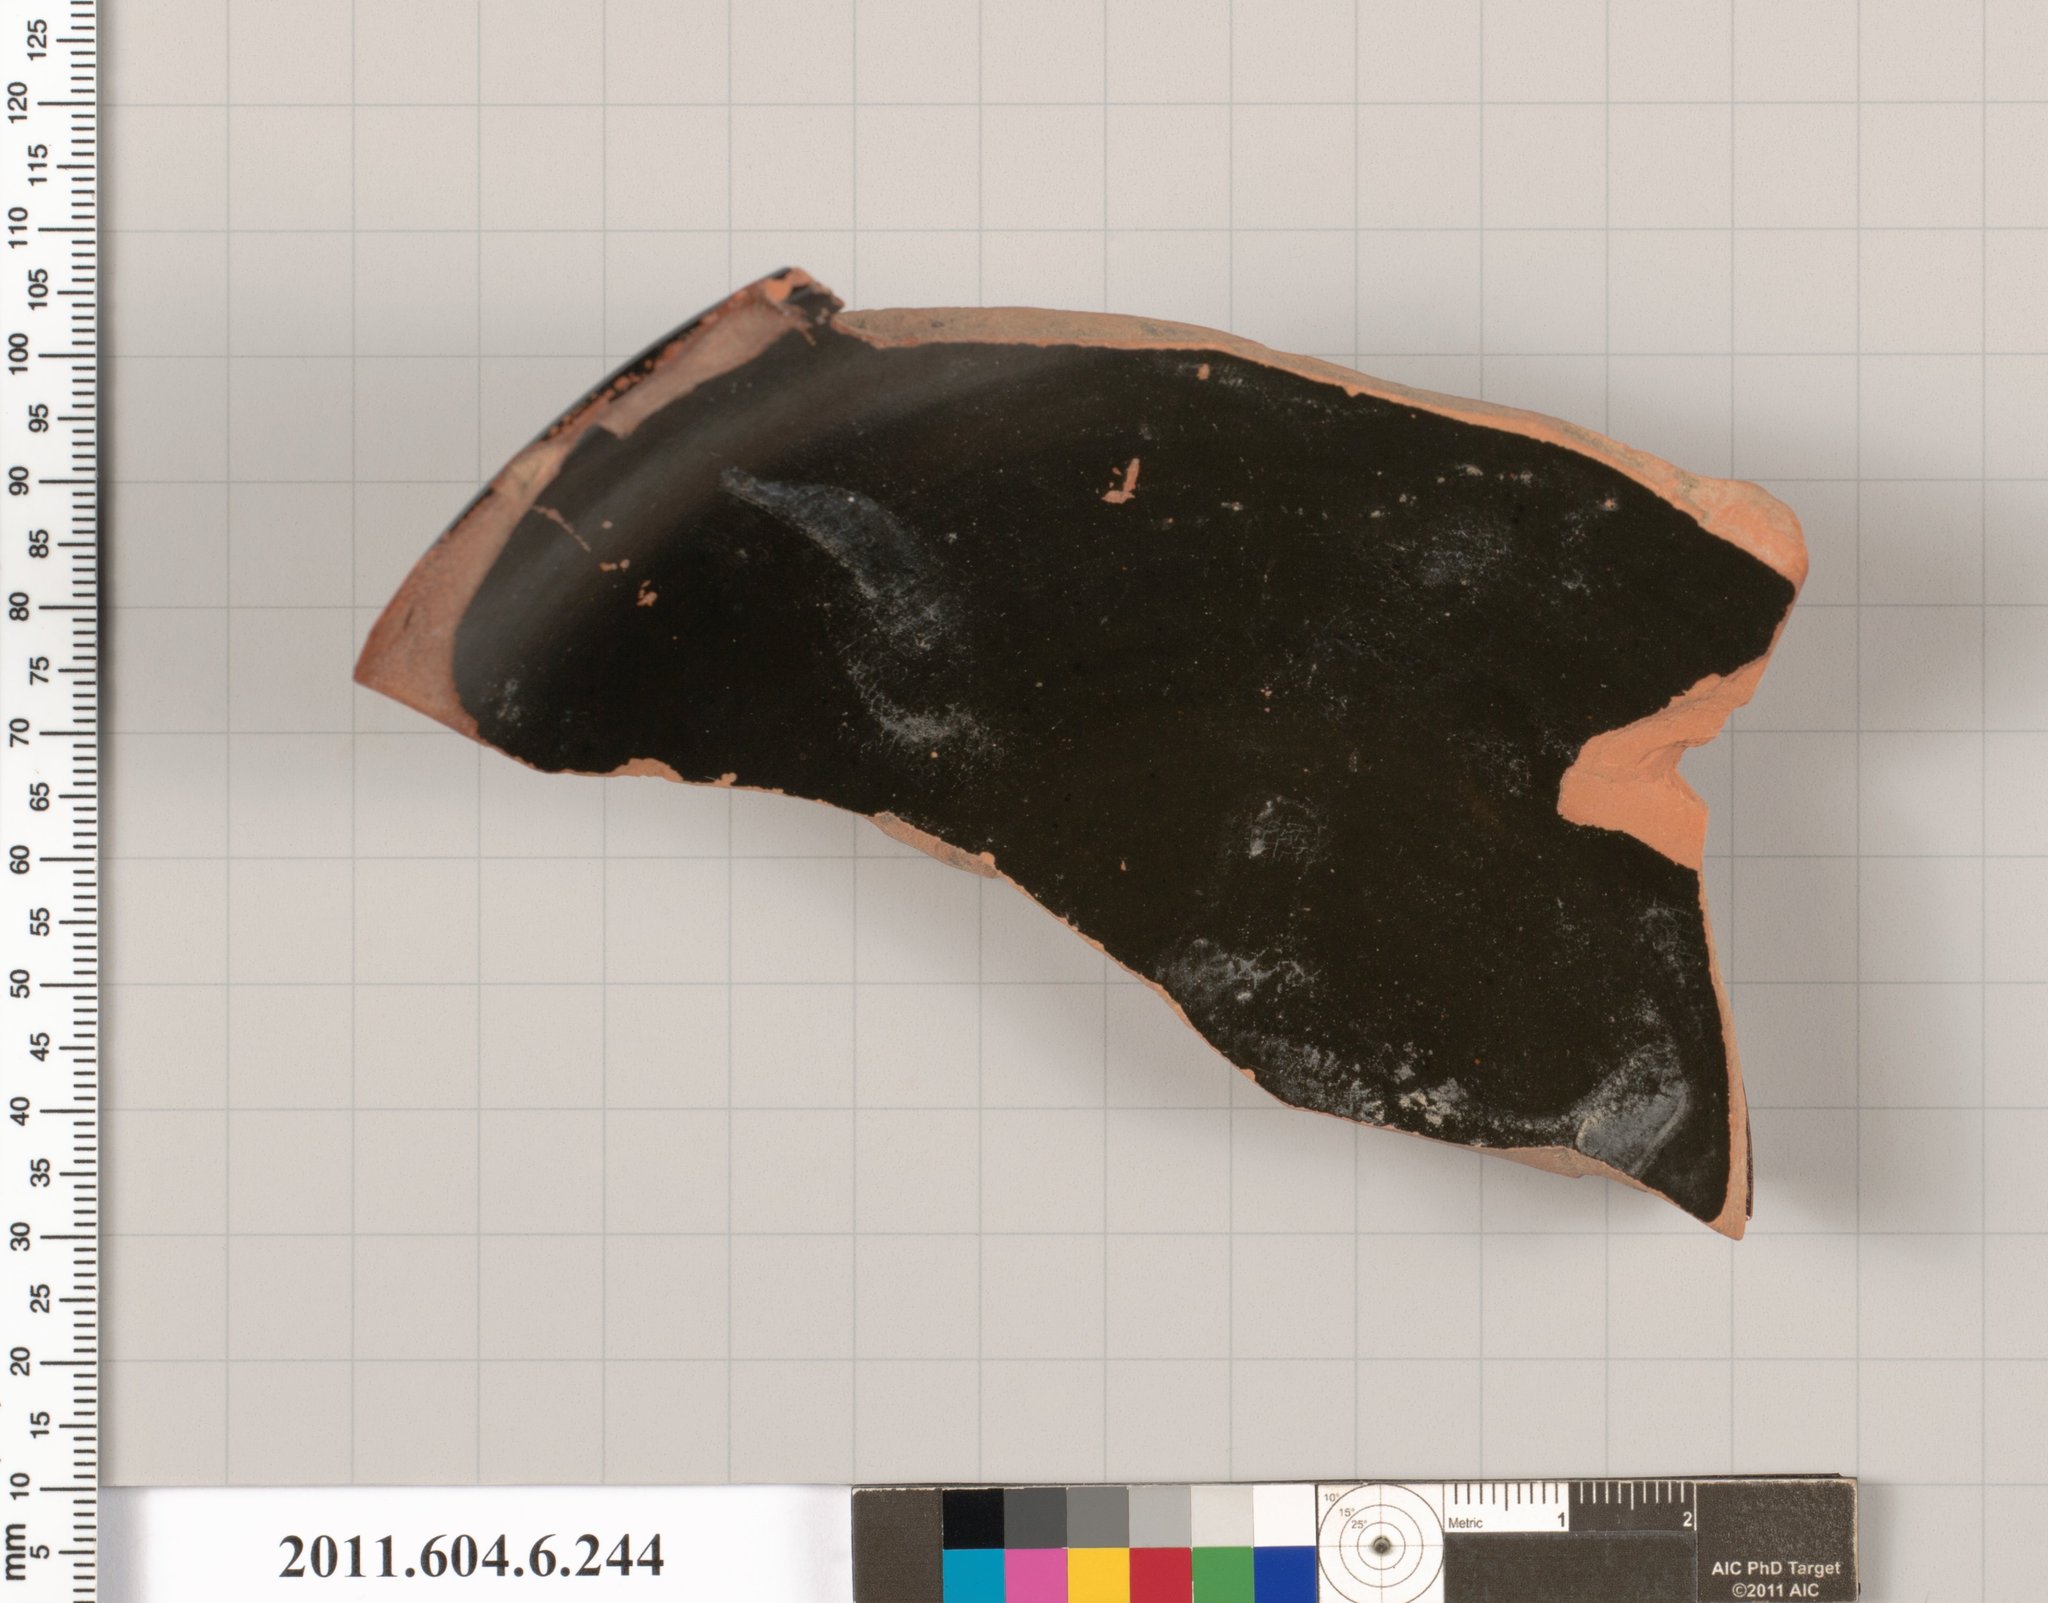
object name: fragment of a bowl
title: Terracotta fragment of a bowl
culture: greek, attic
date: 500-401 BCE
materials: terracotta